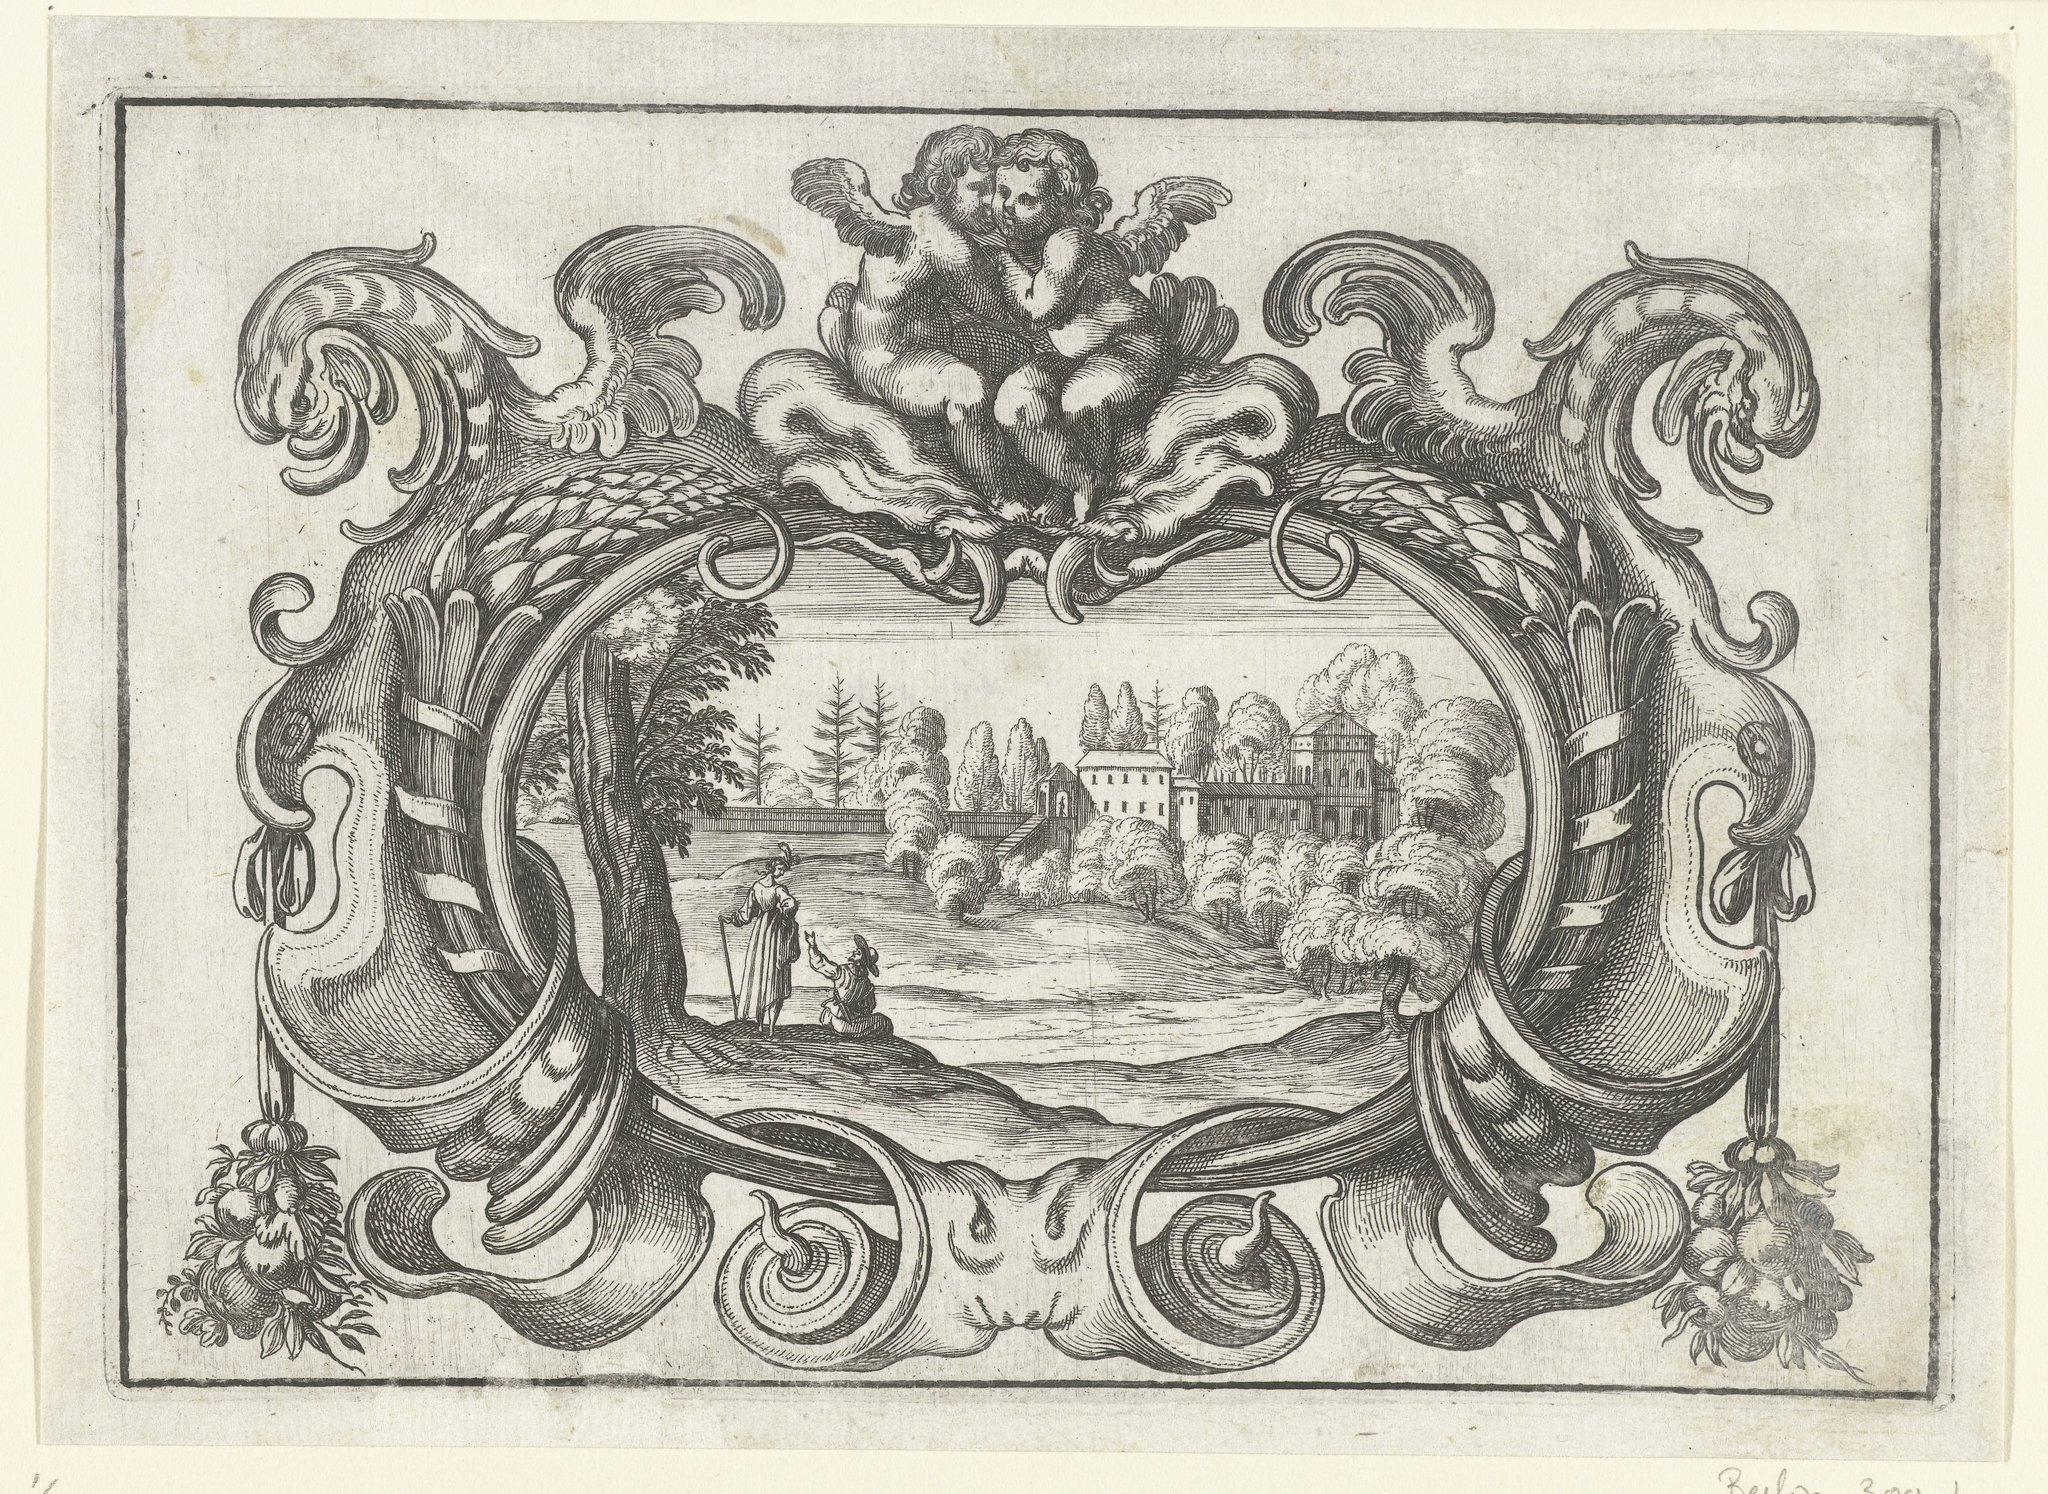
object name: print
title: Cartouche met twee putti bovenaan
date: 1634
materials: paper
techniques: engraving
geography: france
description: In het compartiment is een landhuis omringd door bomen te zien. Blad 5 uit serie van 13 bladen met cartouches in Franse kwabstijl. Uit eerste editie.